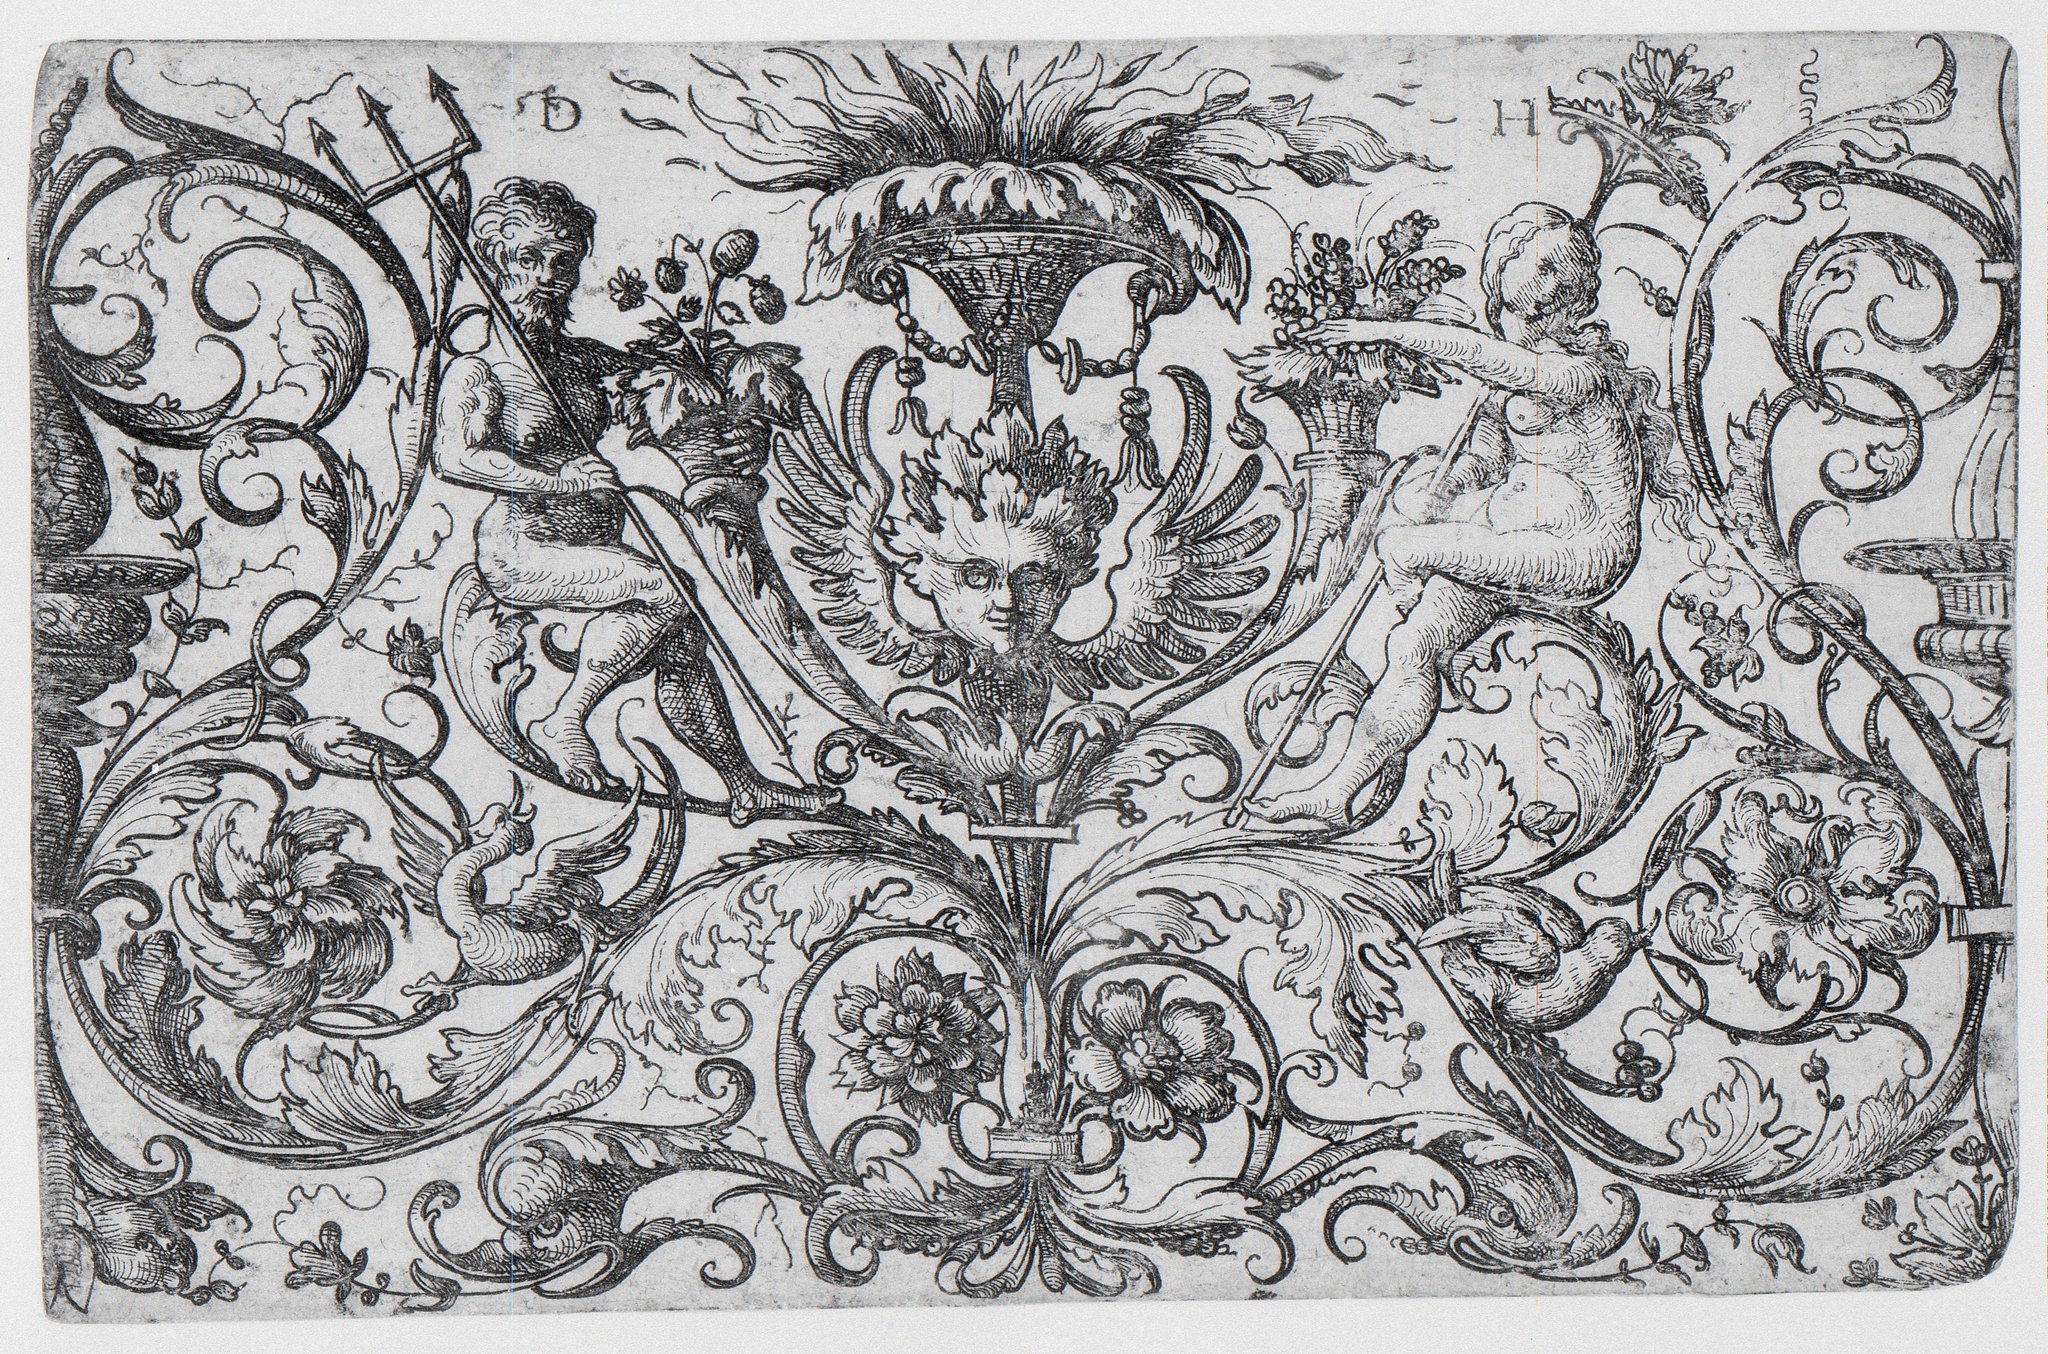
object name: print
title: Ornament met zeegod en een nimf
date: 1480-1536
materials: paper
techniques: etching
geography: germany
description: Vlakdecoratie. In het midden een cherubijn tussen twee hoorns des overvloeds.